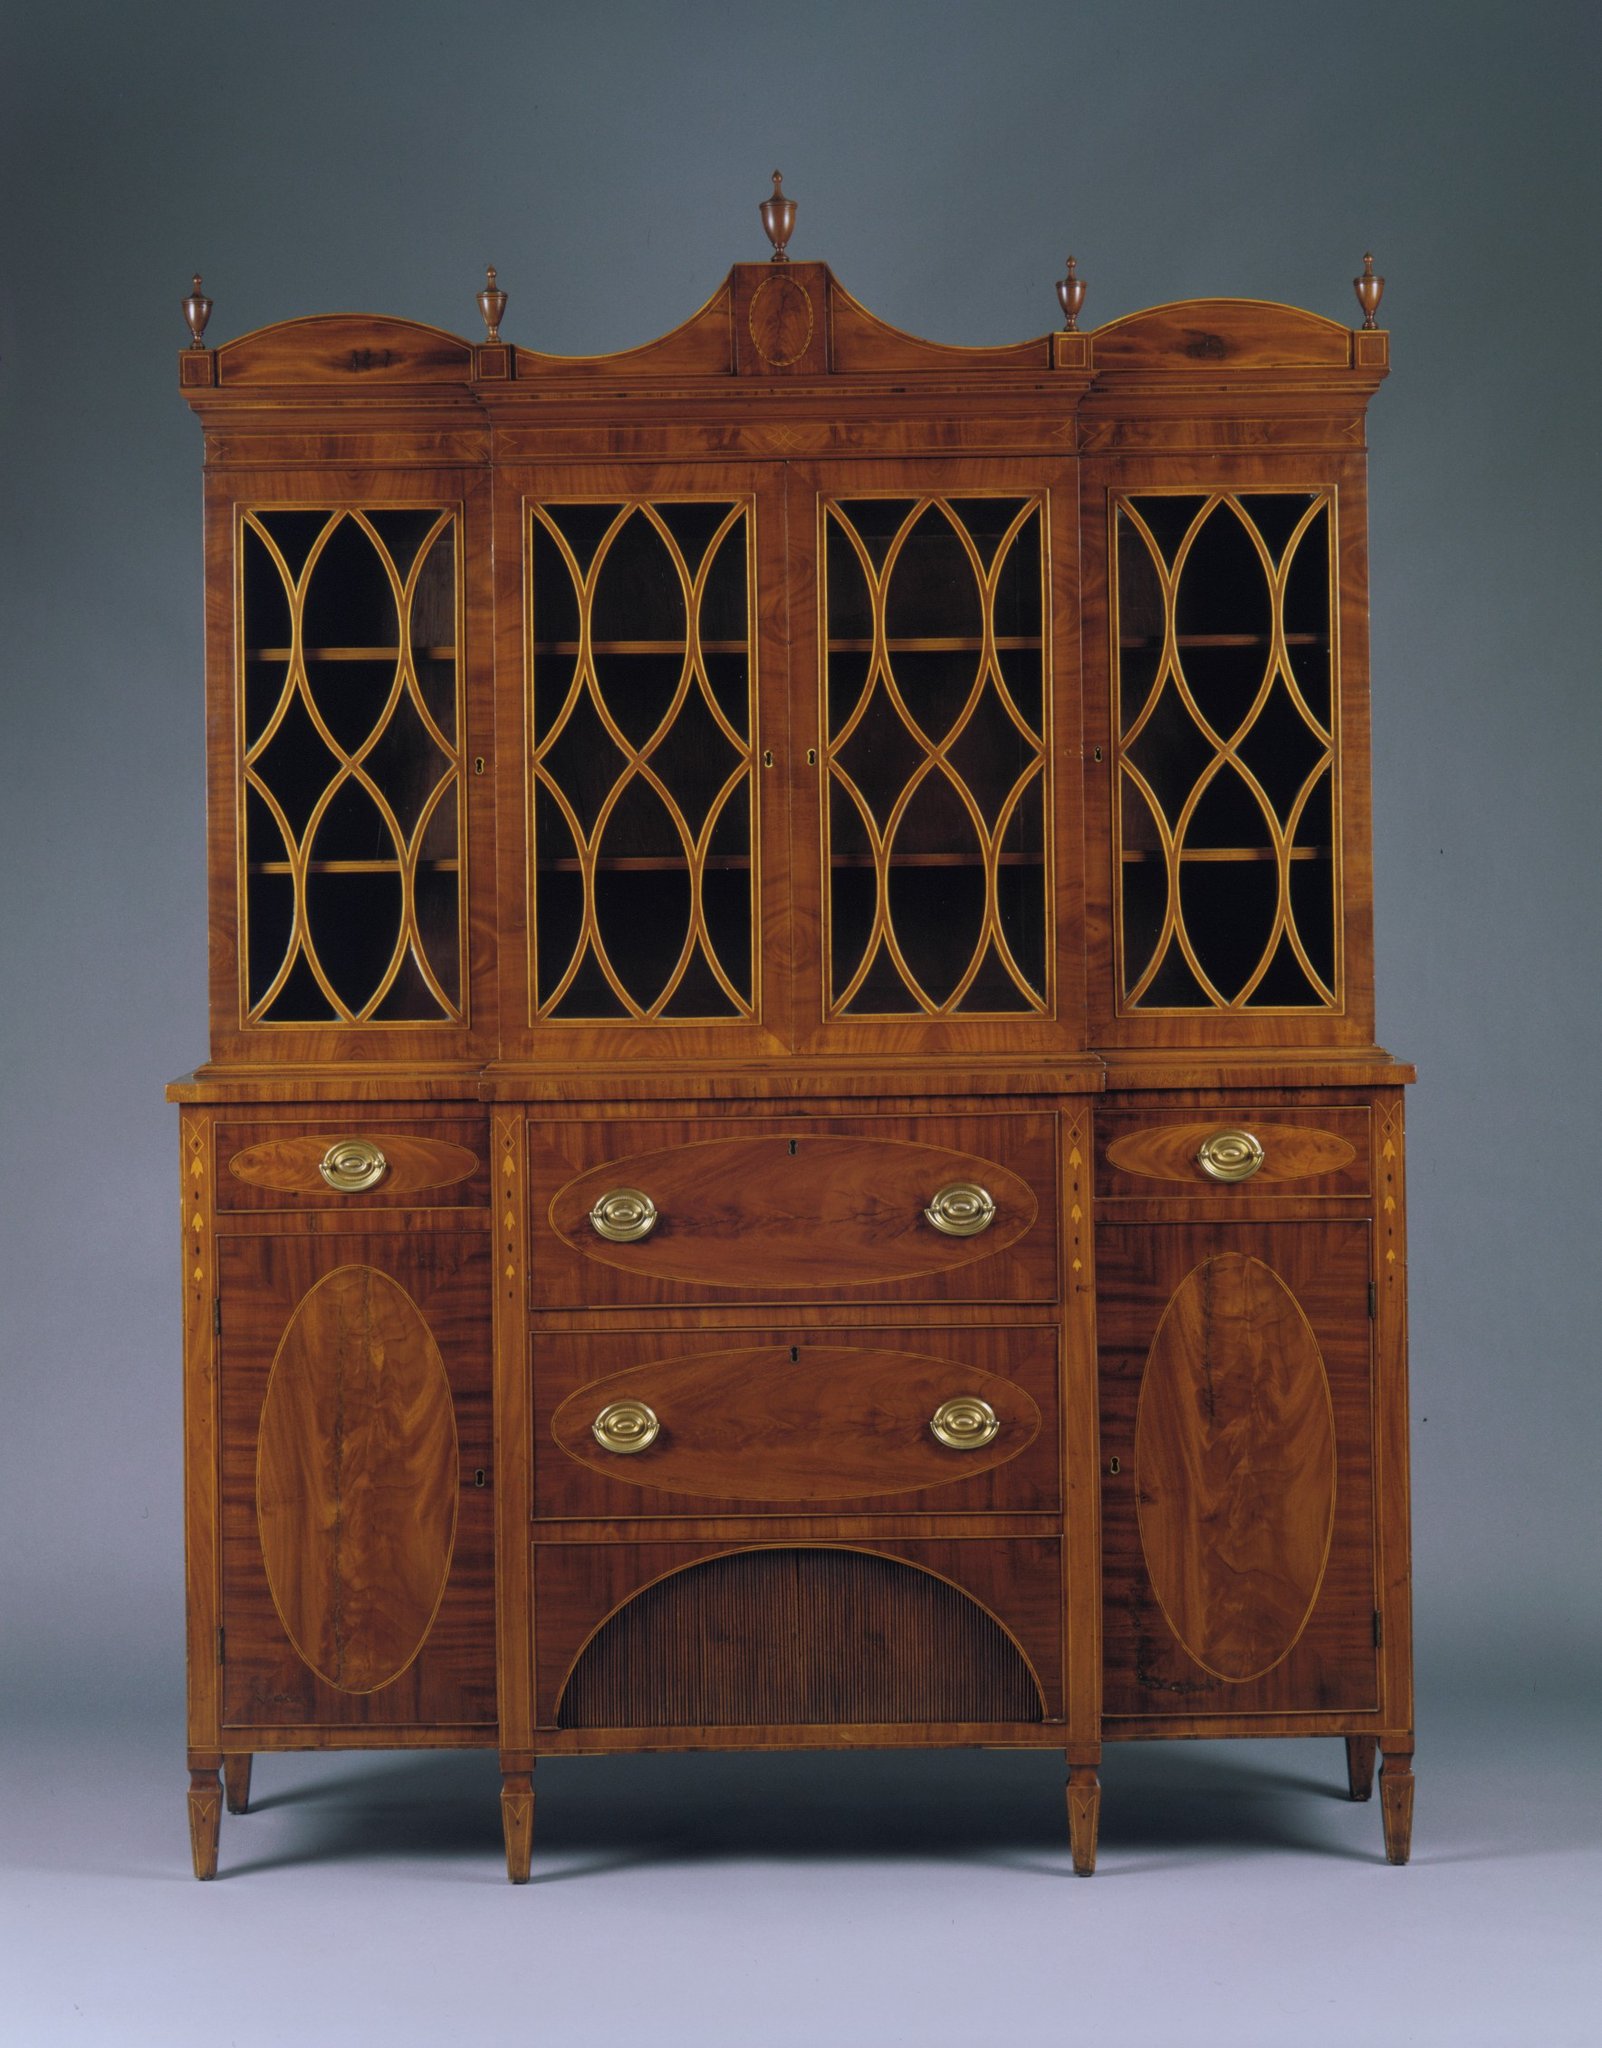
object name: gentleman s secretary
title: Gentleman’s secretary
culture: american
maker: nehemiah adams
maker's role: maker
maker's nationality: american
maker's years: 1769-1840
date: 1800-1810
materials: wood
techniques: veneering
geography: united states